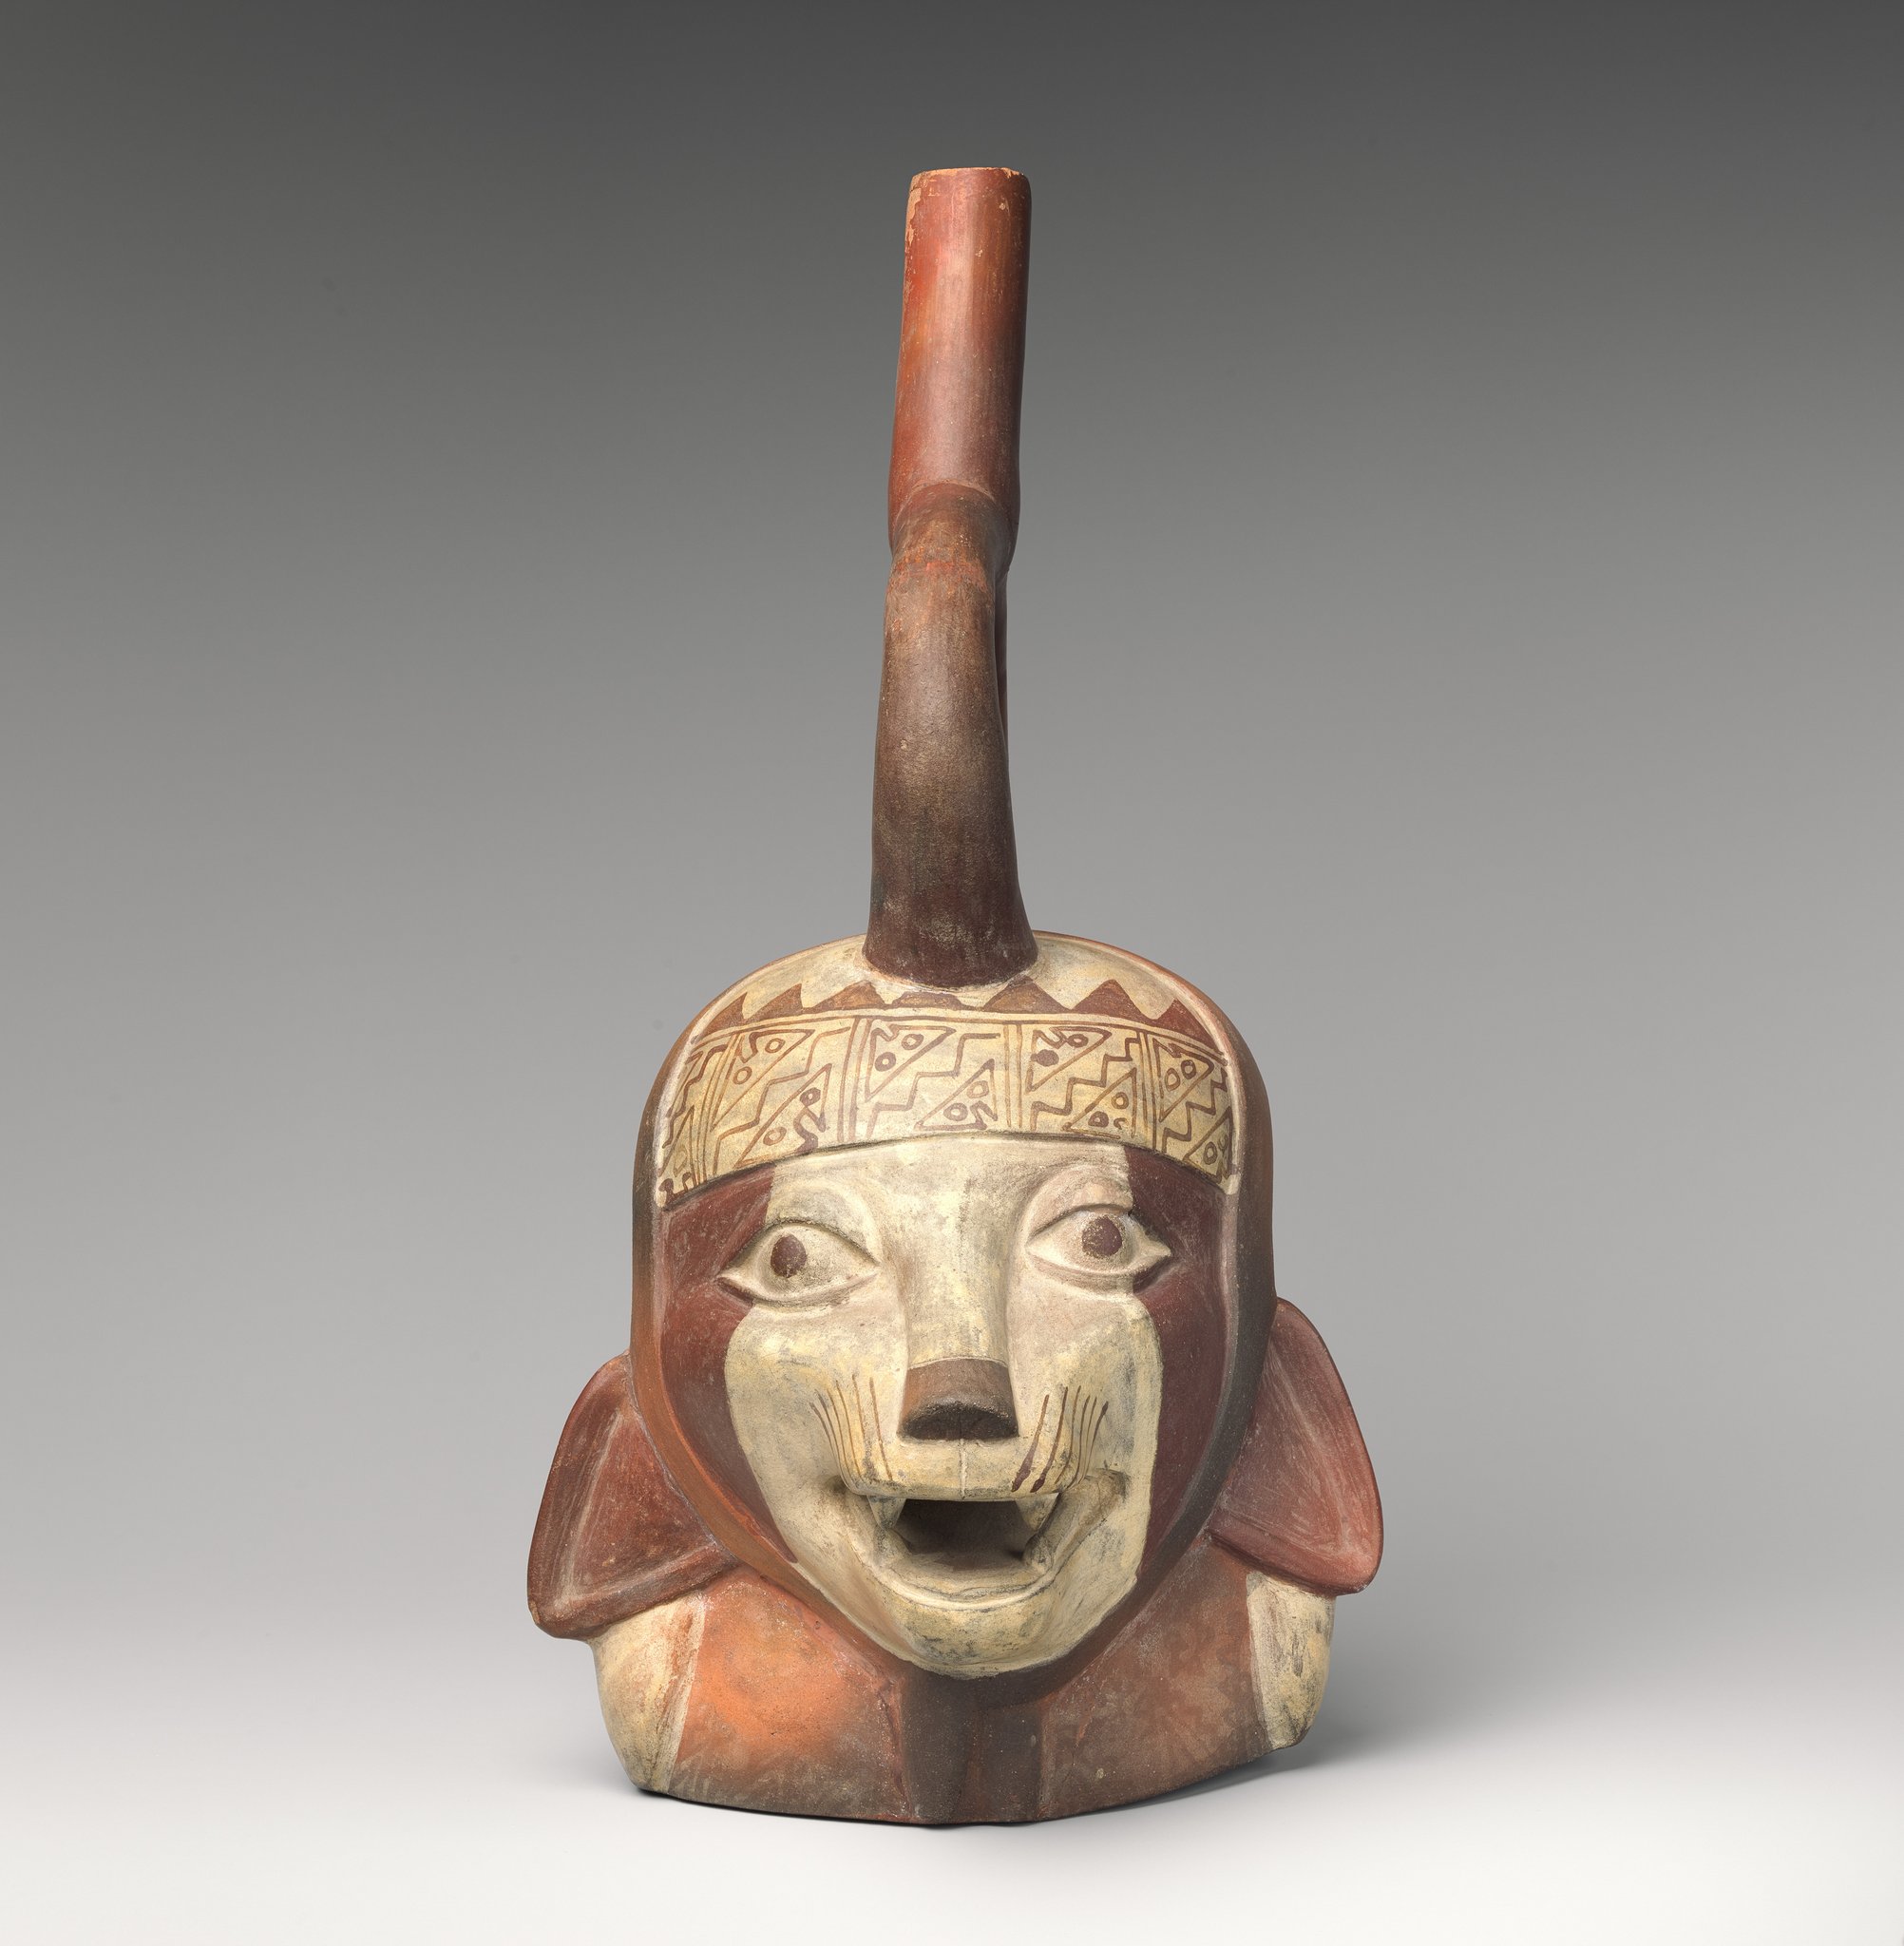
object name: bottle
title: Bottle with fox head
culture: moche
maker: moche artist(s)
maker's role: artist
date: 500-800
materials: ceramic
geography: peru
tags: foxes